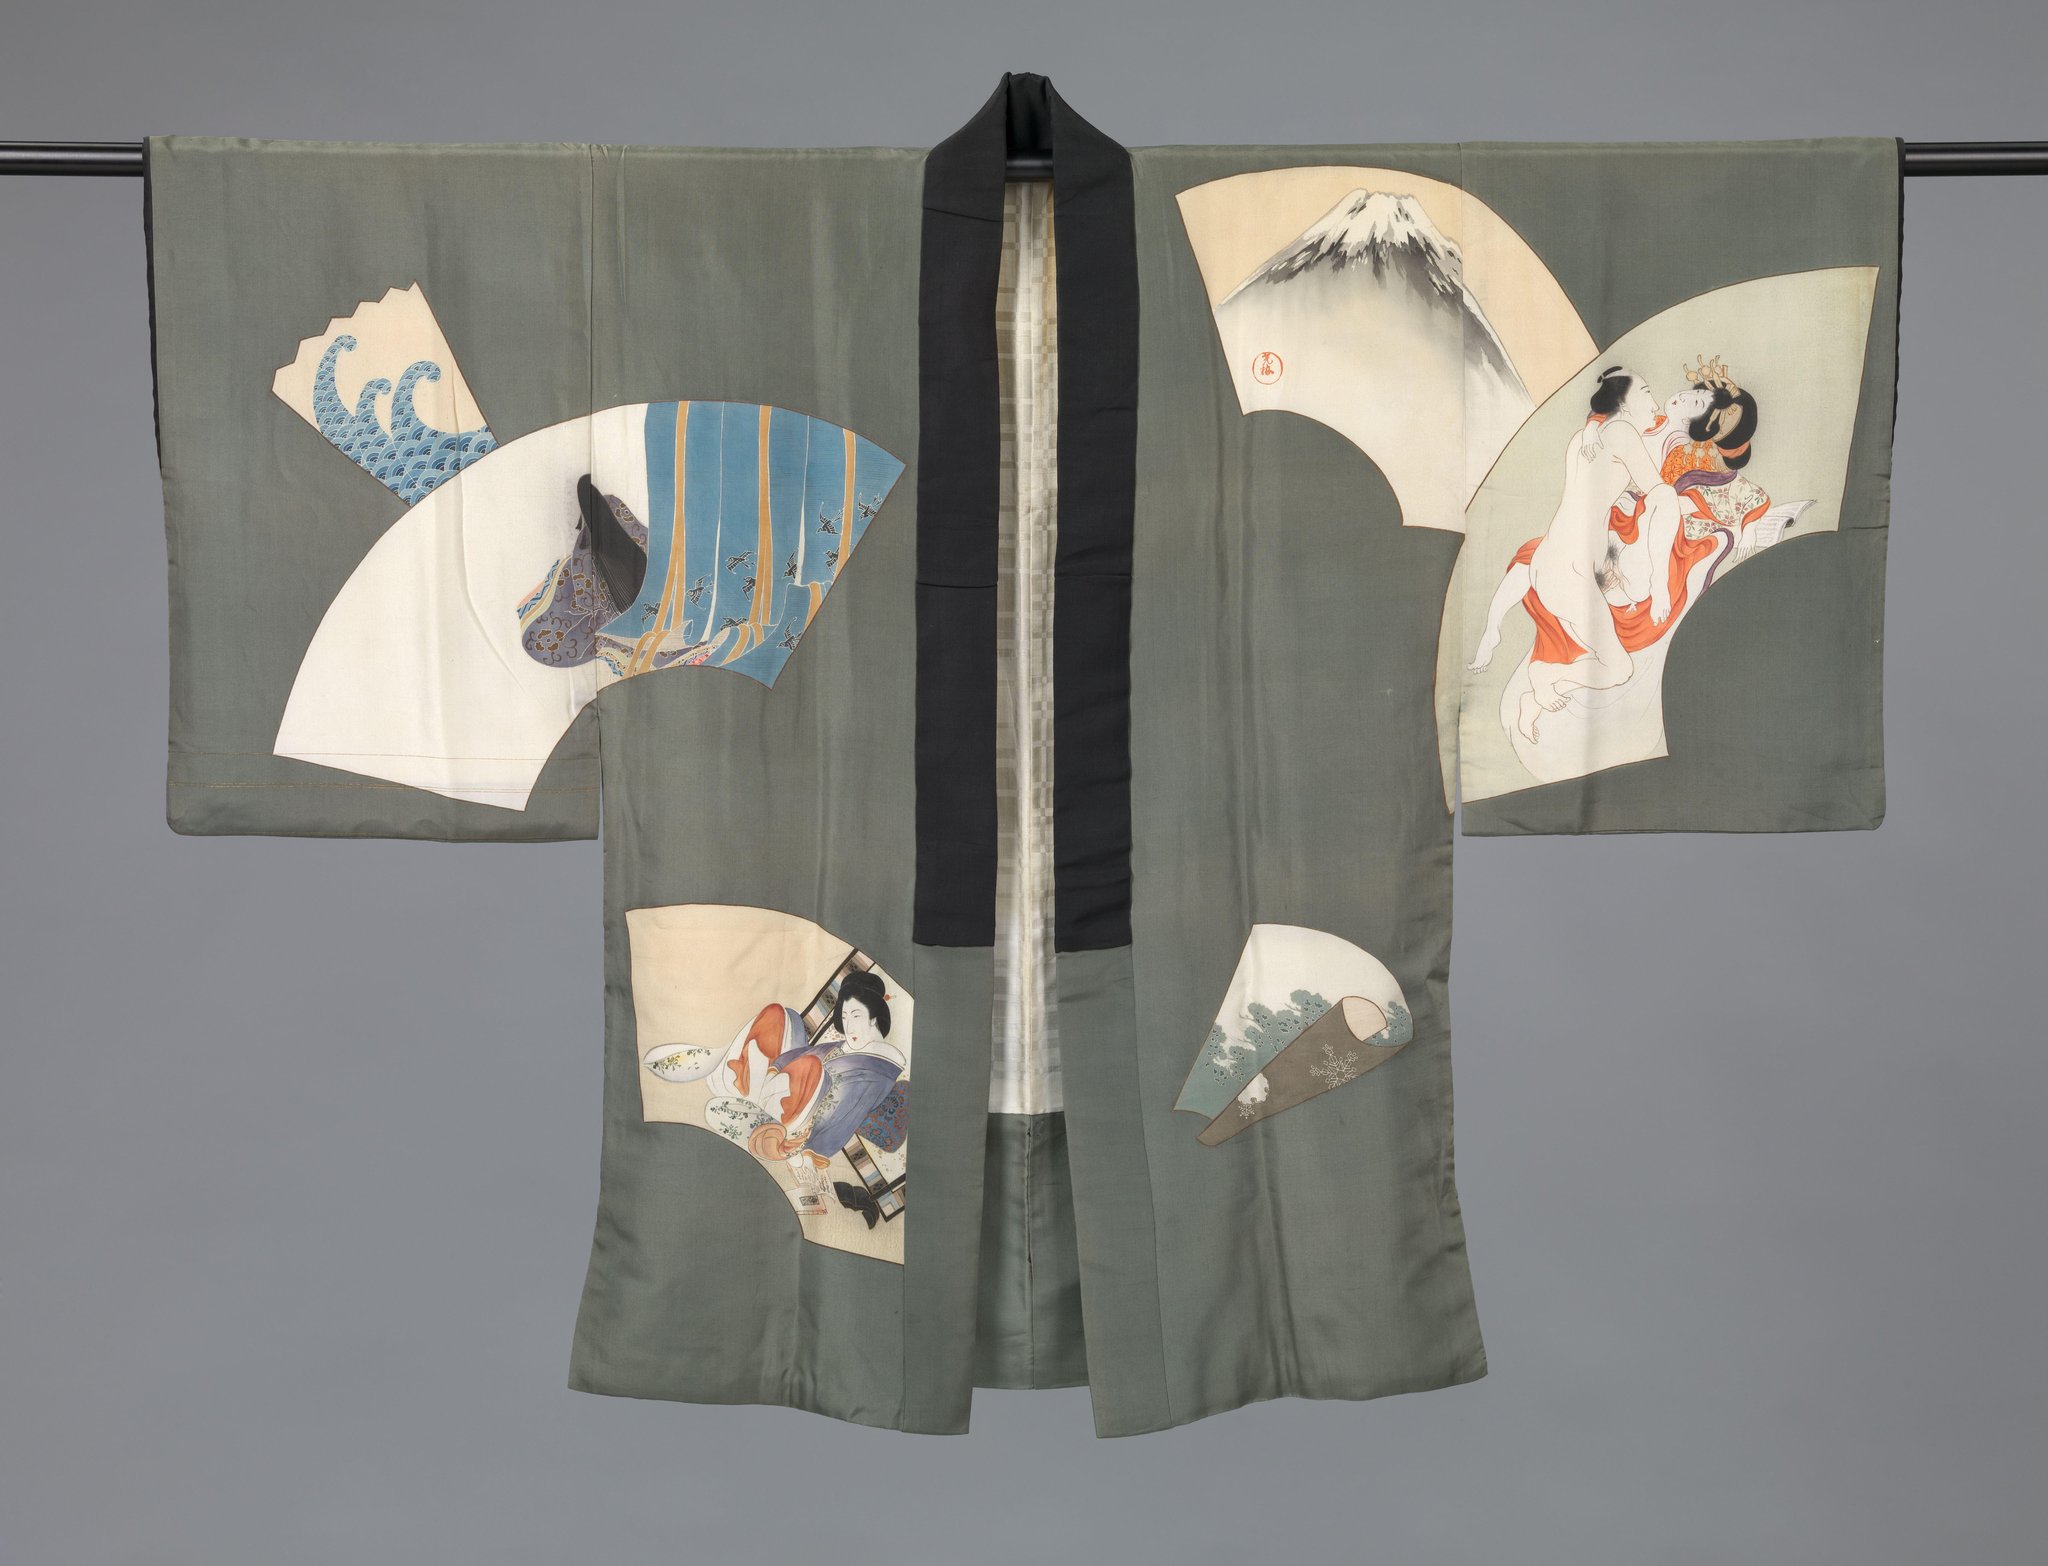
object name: menswear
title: Man’s under-kimono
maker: Anonymous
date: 1920-1940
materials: paint, silk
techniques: weave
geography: japan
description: An under-kimono was always hidden by the kimono and only rarely visible. The owner’s taste here finds expression in several hand-painted scenes, of which one is erotic, set in fan-shaped cartouches.